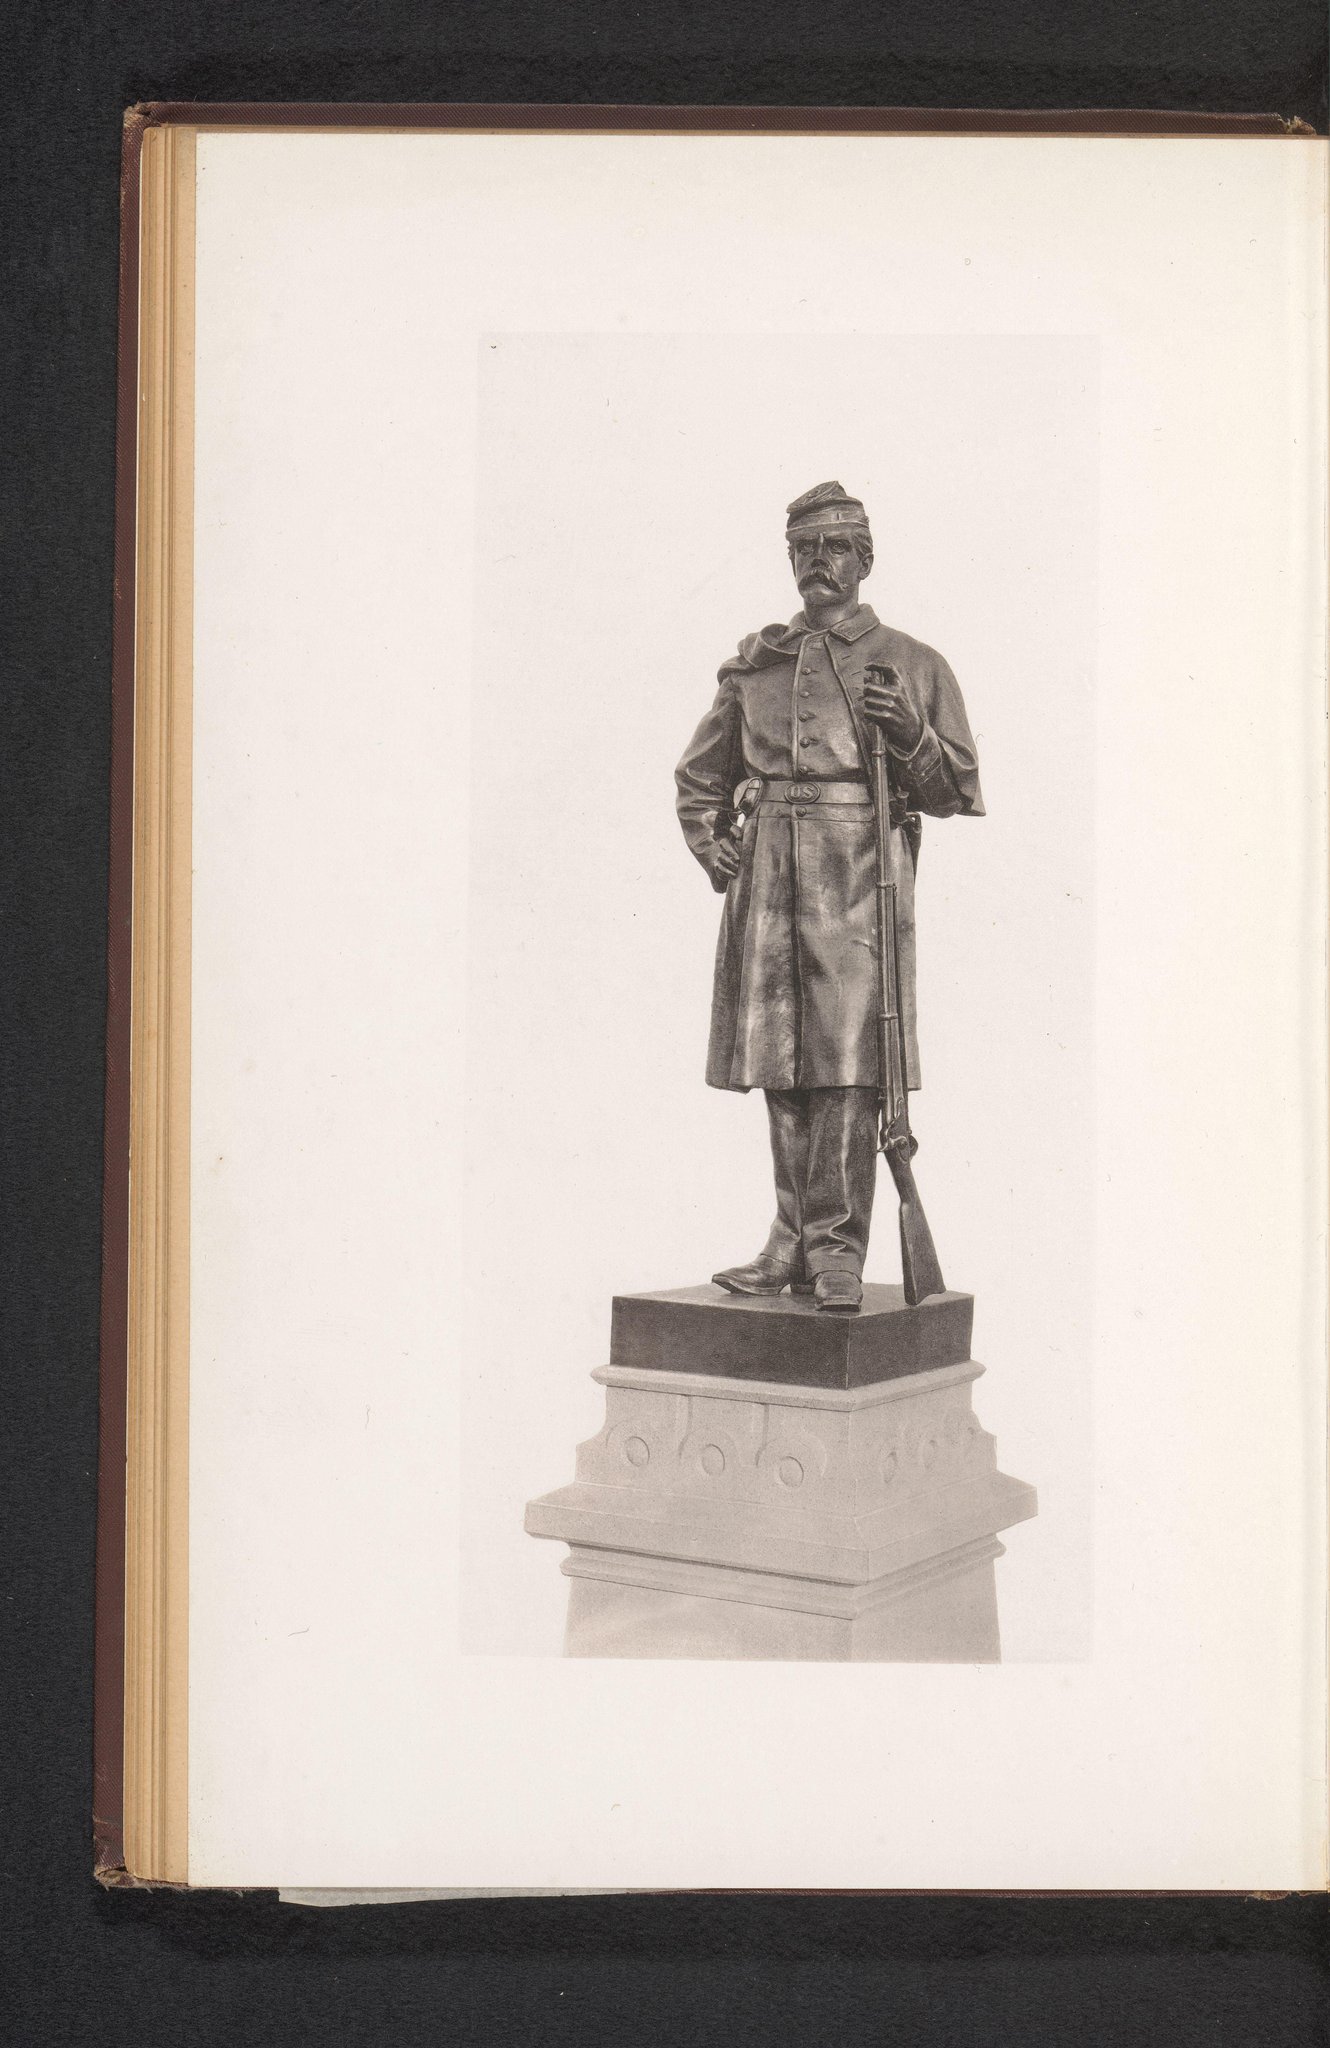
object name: page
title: Gezicht op een detail van het monument te Manchester ter nagedachtenis van de burgeroorlog; lid van de infanterie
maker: Anonymous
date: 1875-1880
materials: paper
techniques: photograph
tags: monument, statue, the soldier; the soldier's life